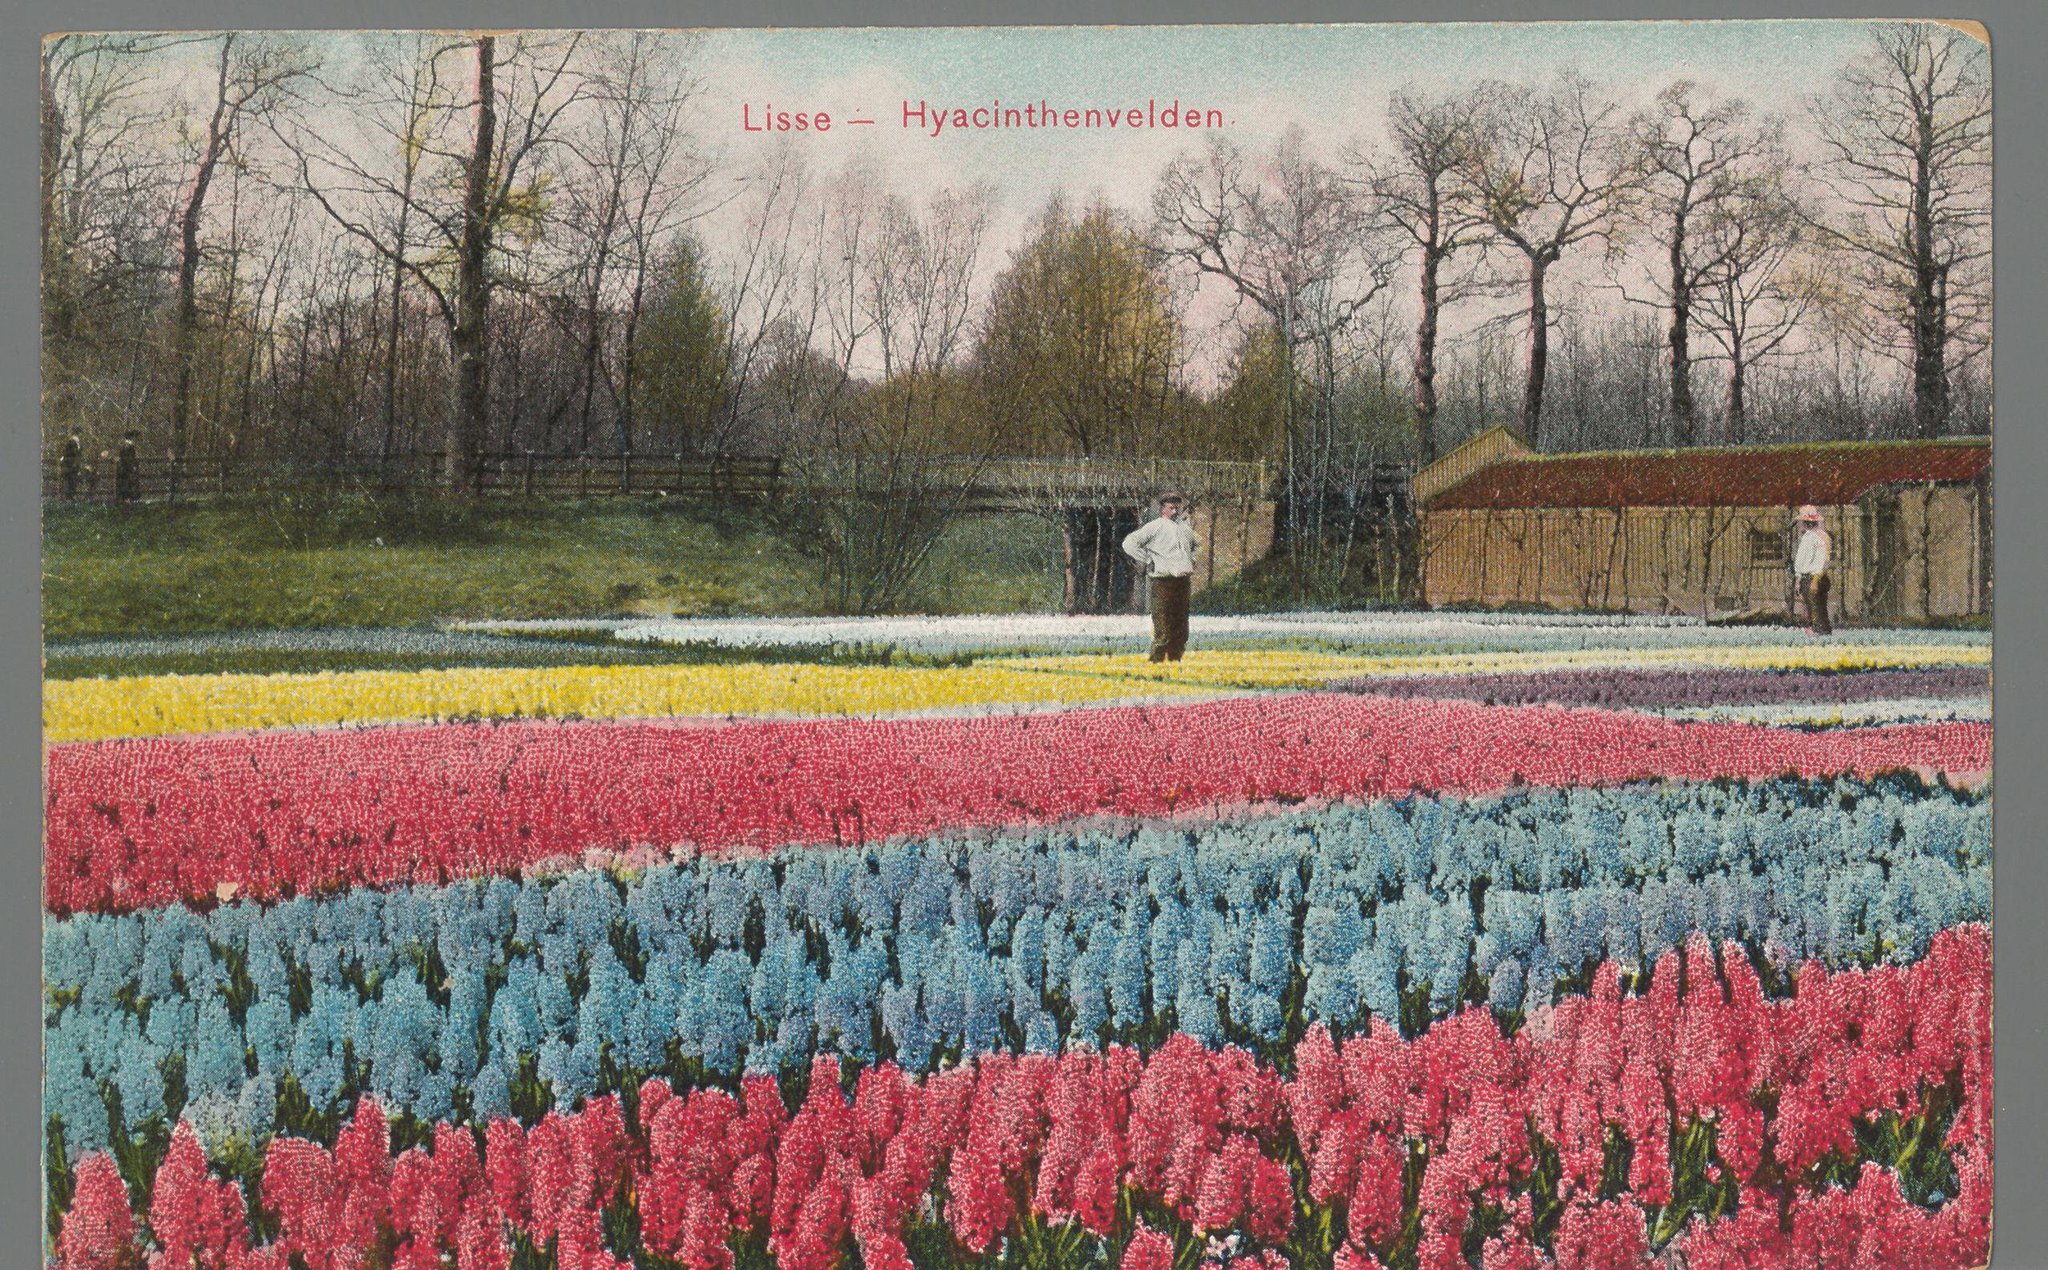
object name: photomechanical print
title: Lisse - hyacinthenvelden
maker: Anonymous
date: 1907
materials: cardboard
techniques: lithograph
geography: leipzig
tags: bulb field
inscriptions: date